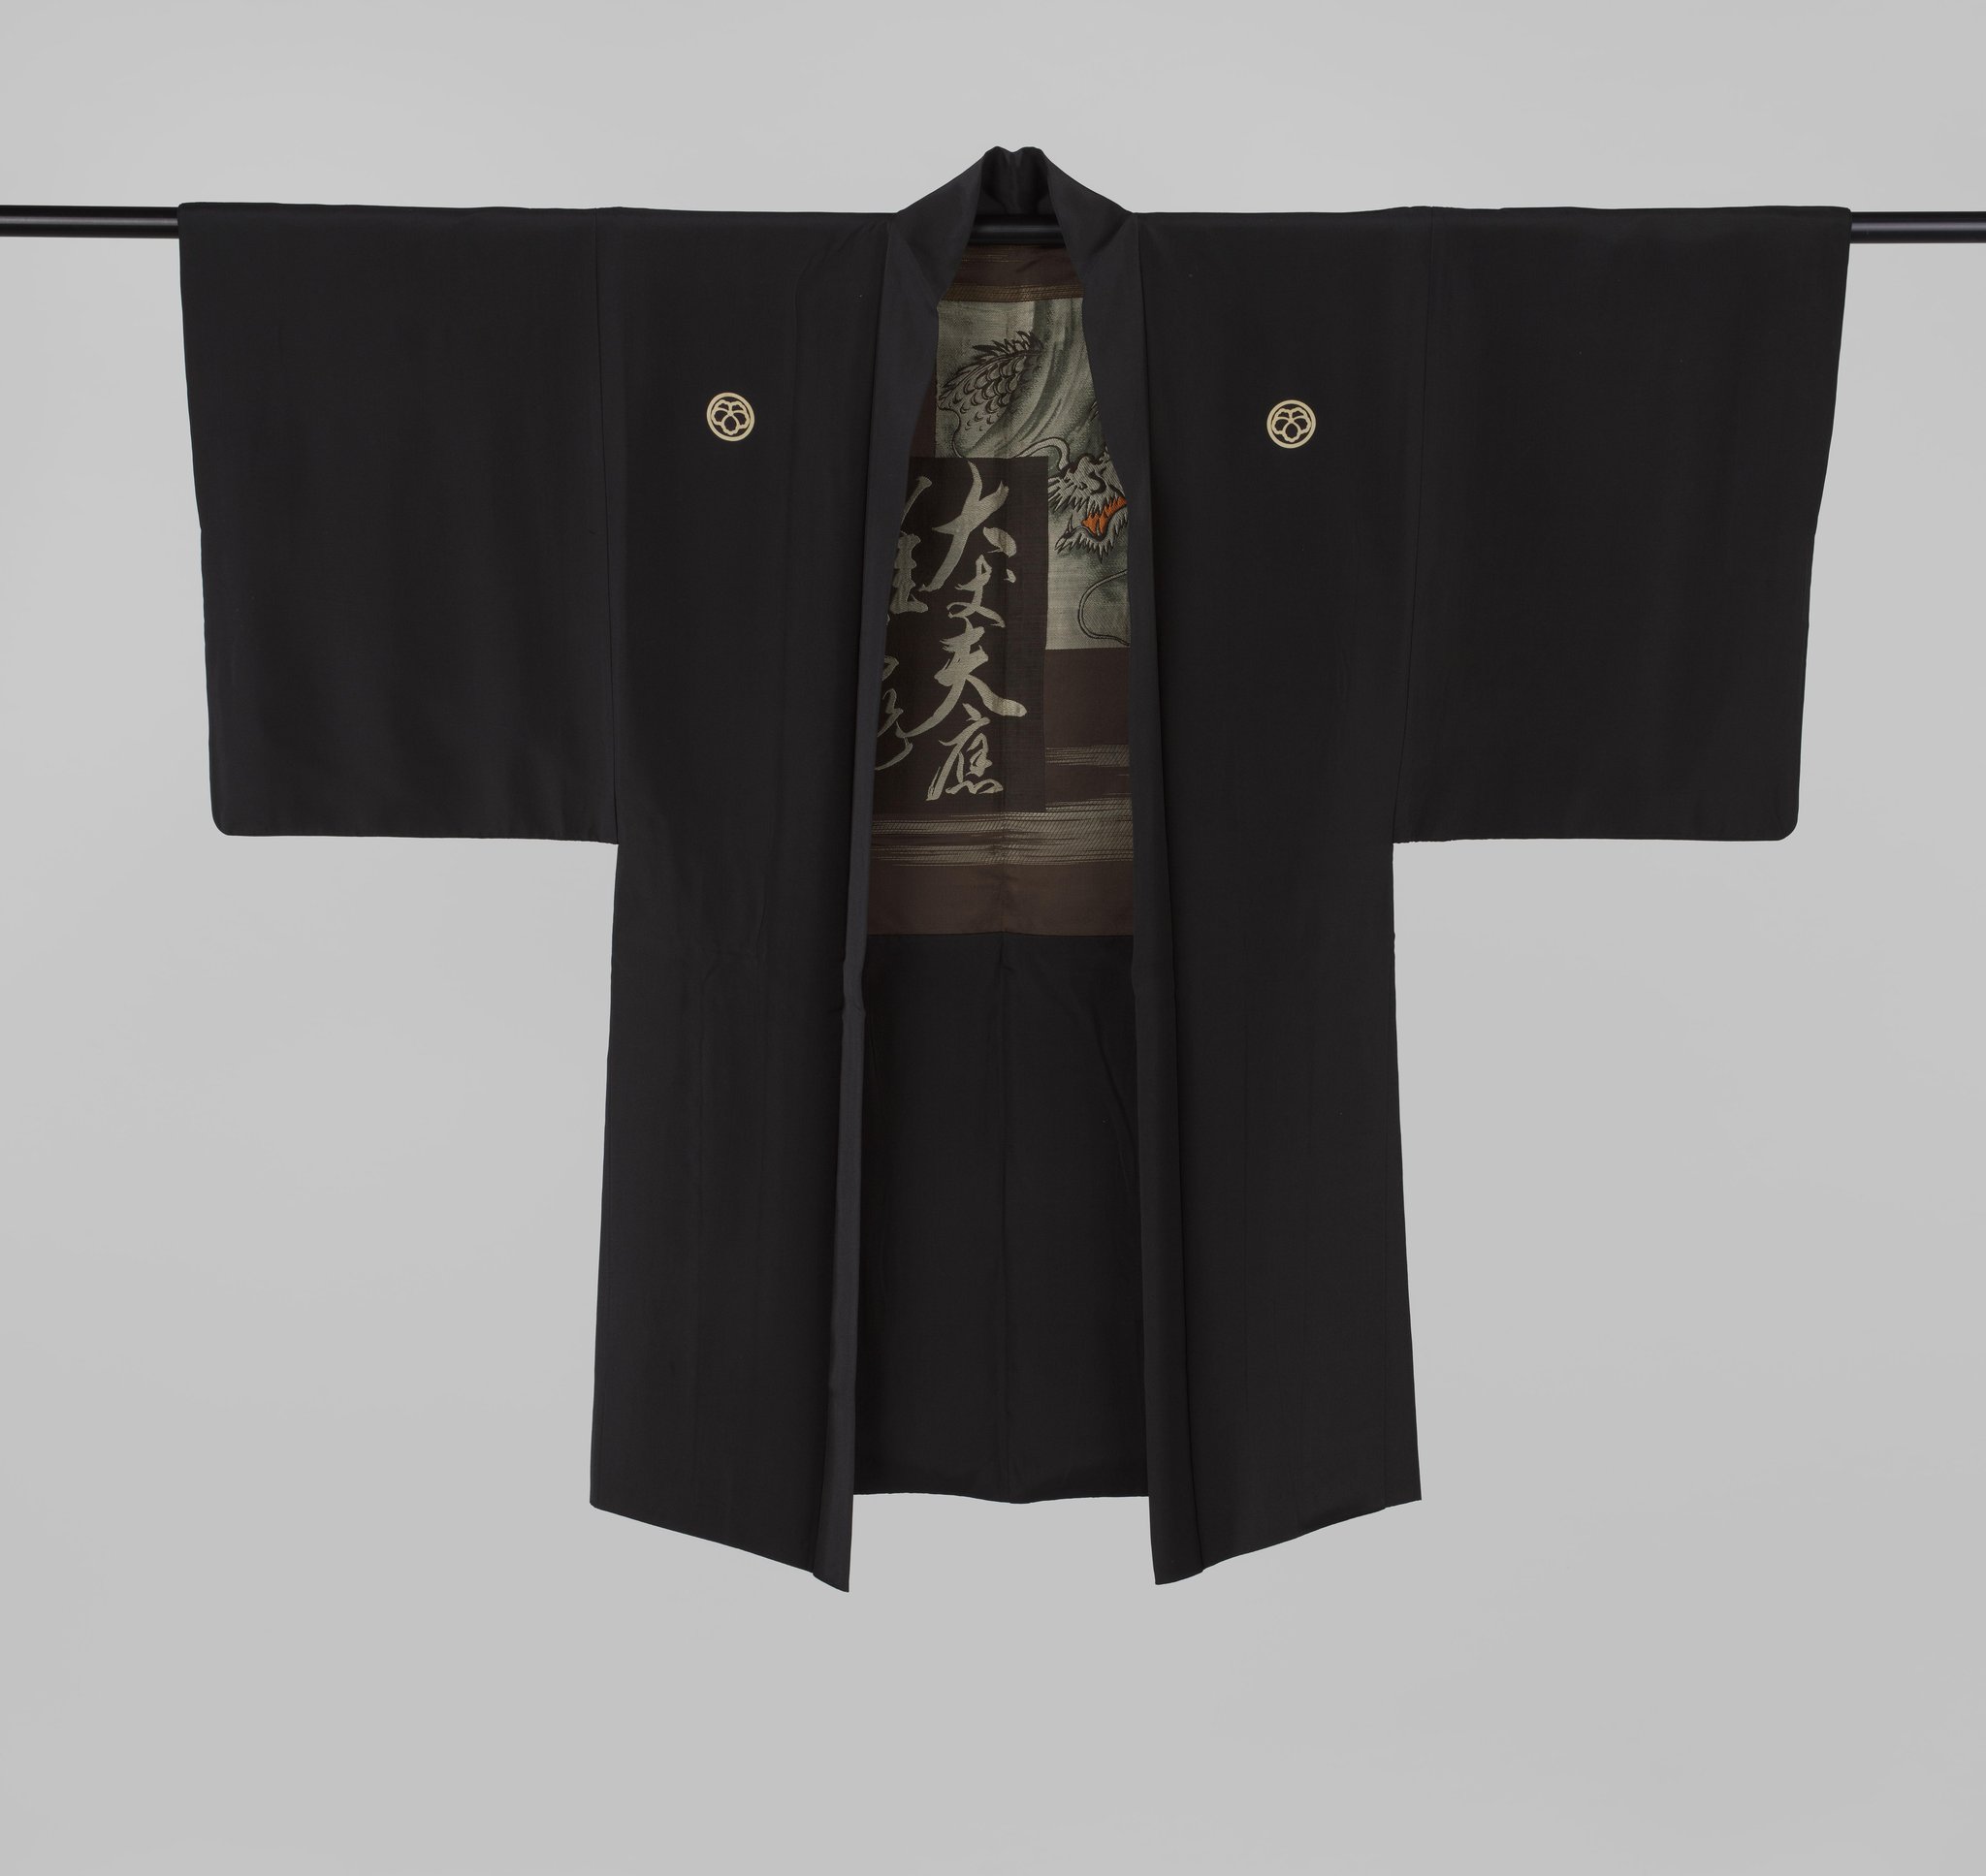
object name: kimono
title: Mannen haori met draak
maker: Anonymous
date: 1920-1940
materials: silk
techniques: weave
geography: japan